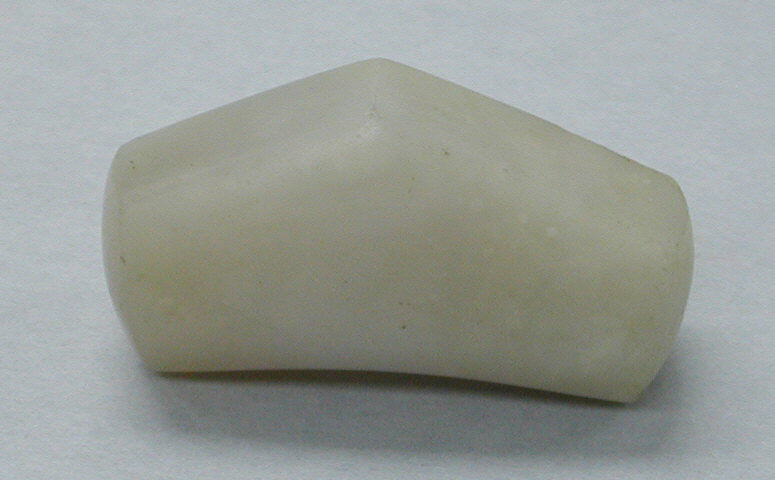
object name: ritual stone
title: Stone Pulidor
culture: mexican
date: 1501-1600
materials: stone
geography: mexico